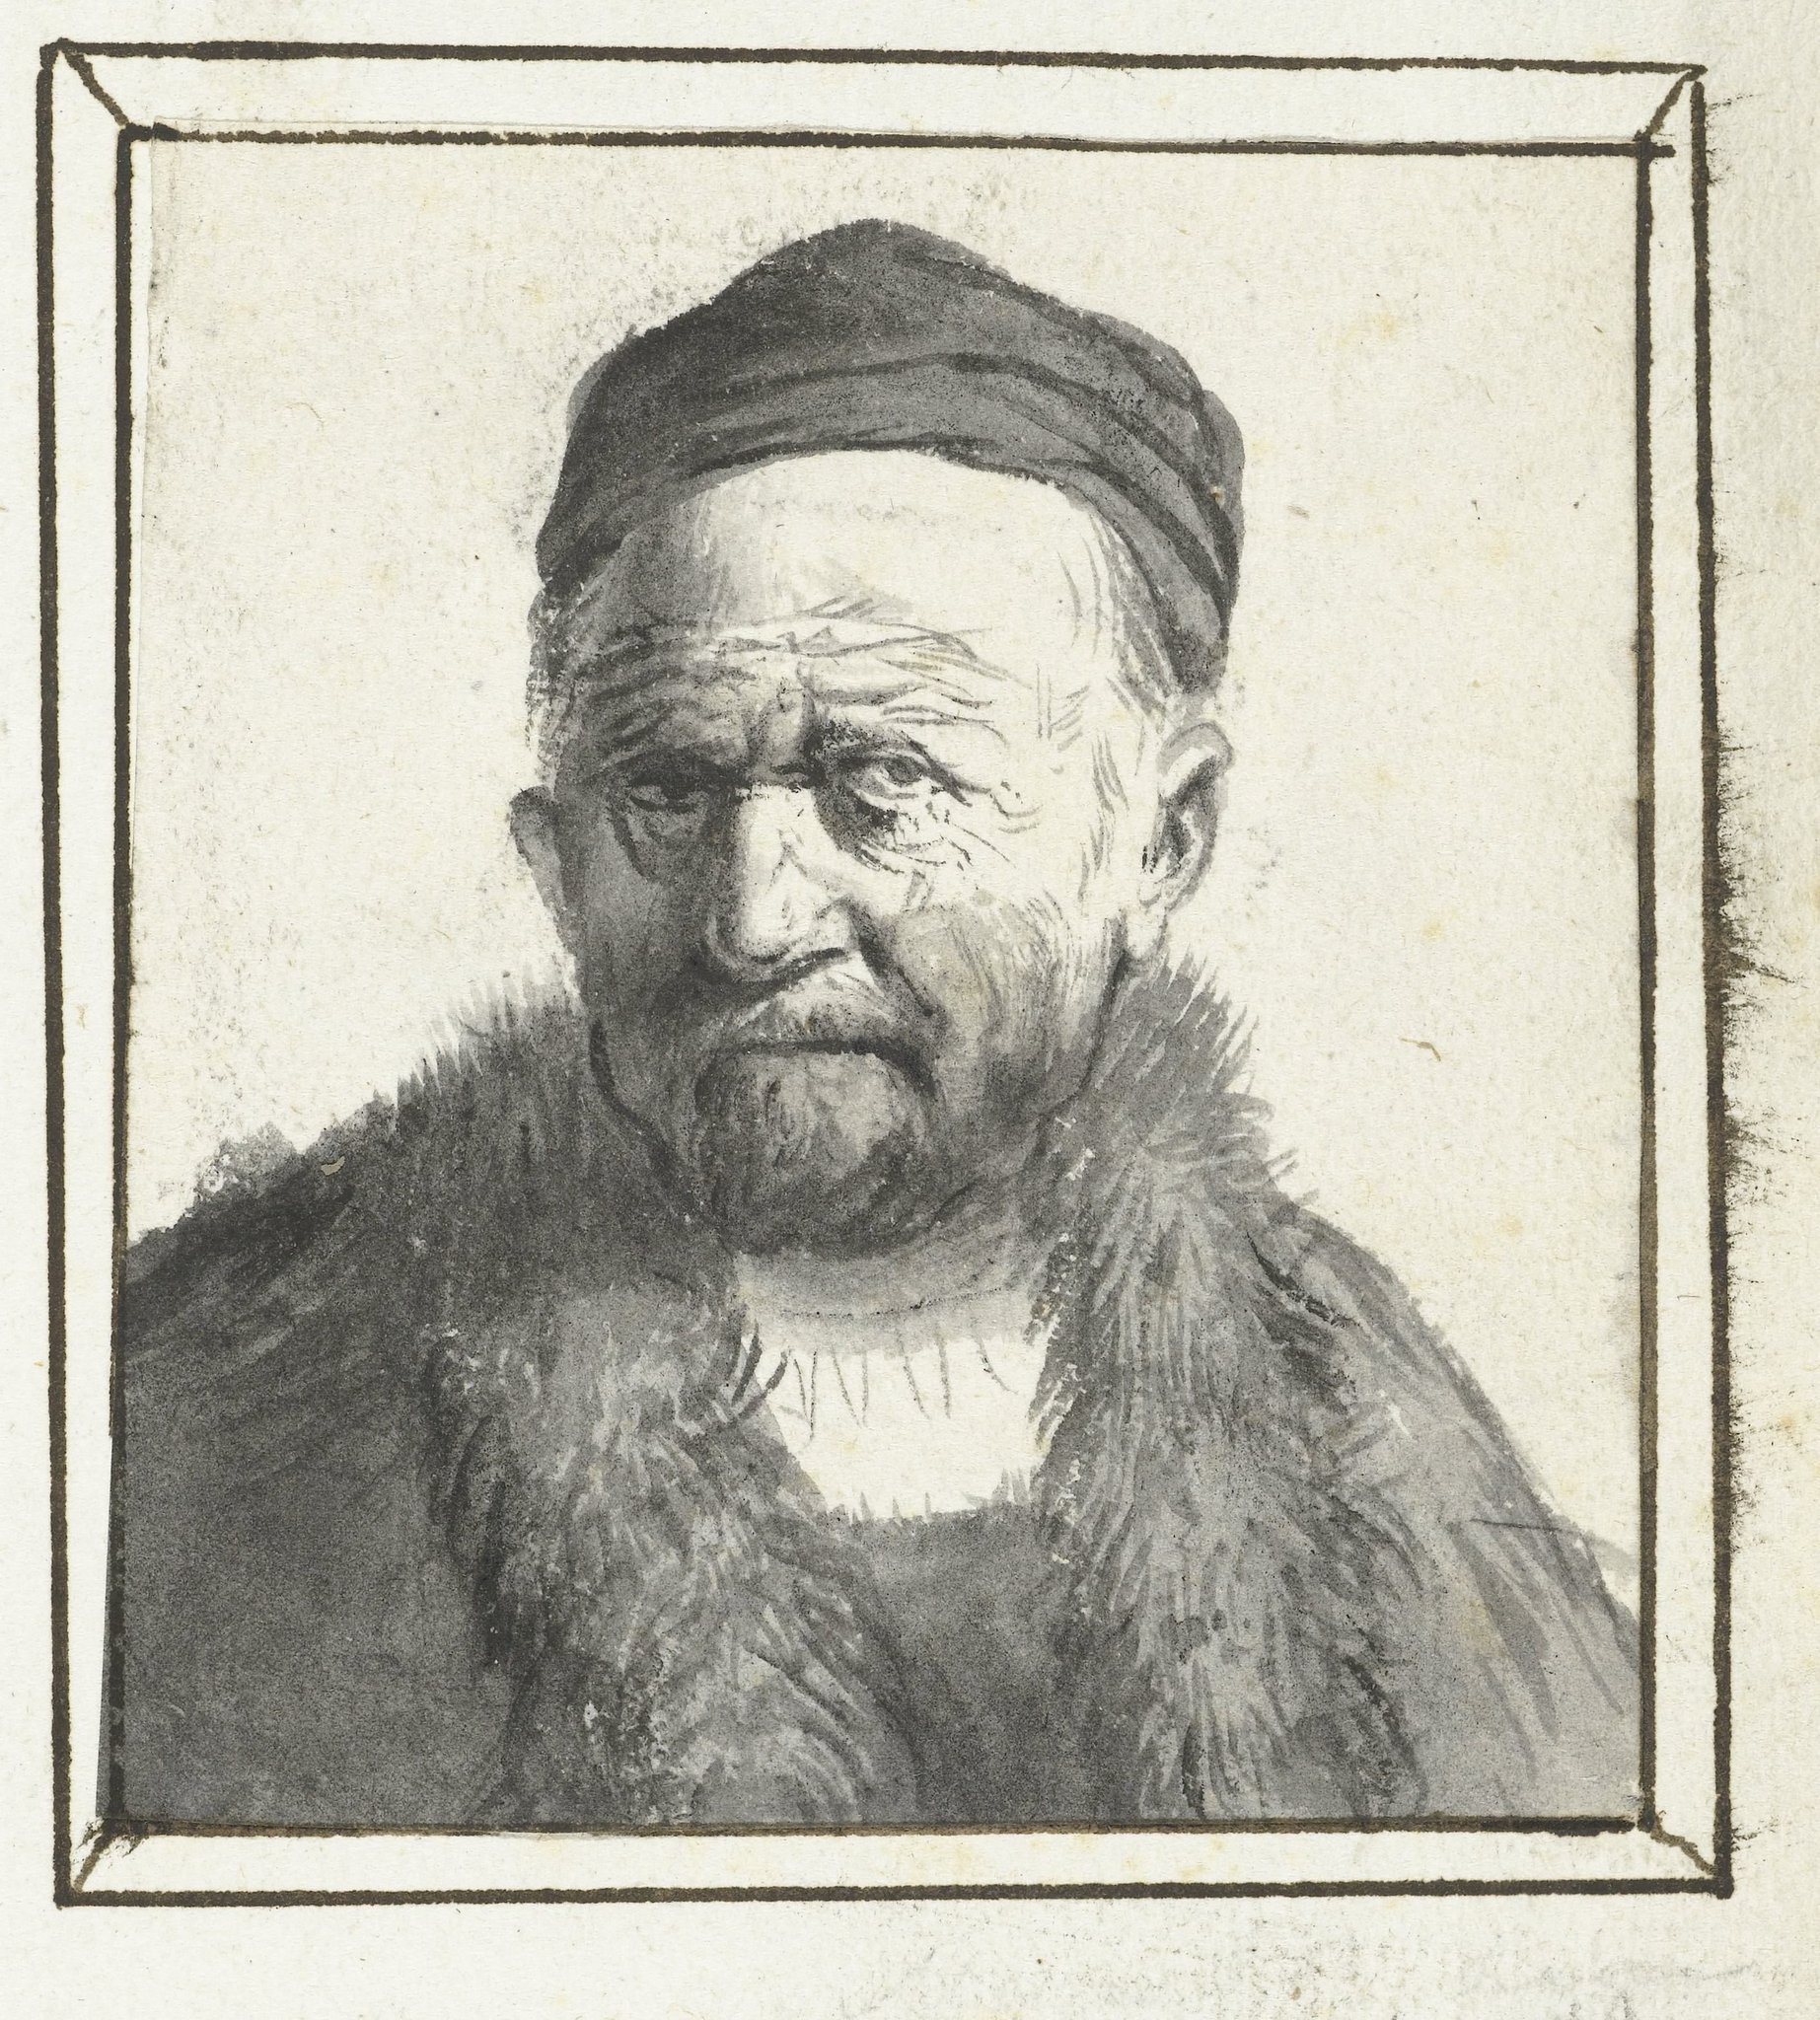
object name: drawing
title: Buste van een man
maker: moses ter borch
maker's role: draughtsman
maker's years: 1645-1667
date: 1630-1667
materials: chalk, ink, paper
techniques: brush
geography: zwolle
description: Tekening naast twee andere tekeningen in het Familie-plakboek geplakt. Vrije kopie naar Rembrandts ets 'Man met kalotje: buste' uit 1630 (B. 304).